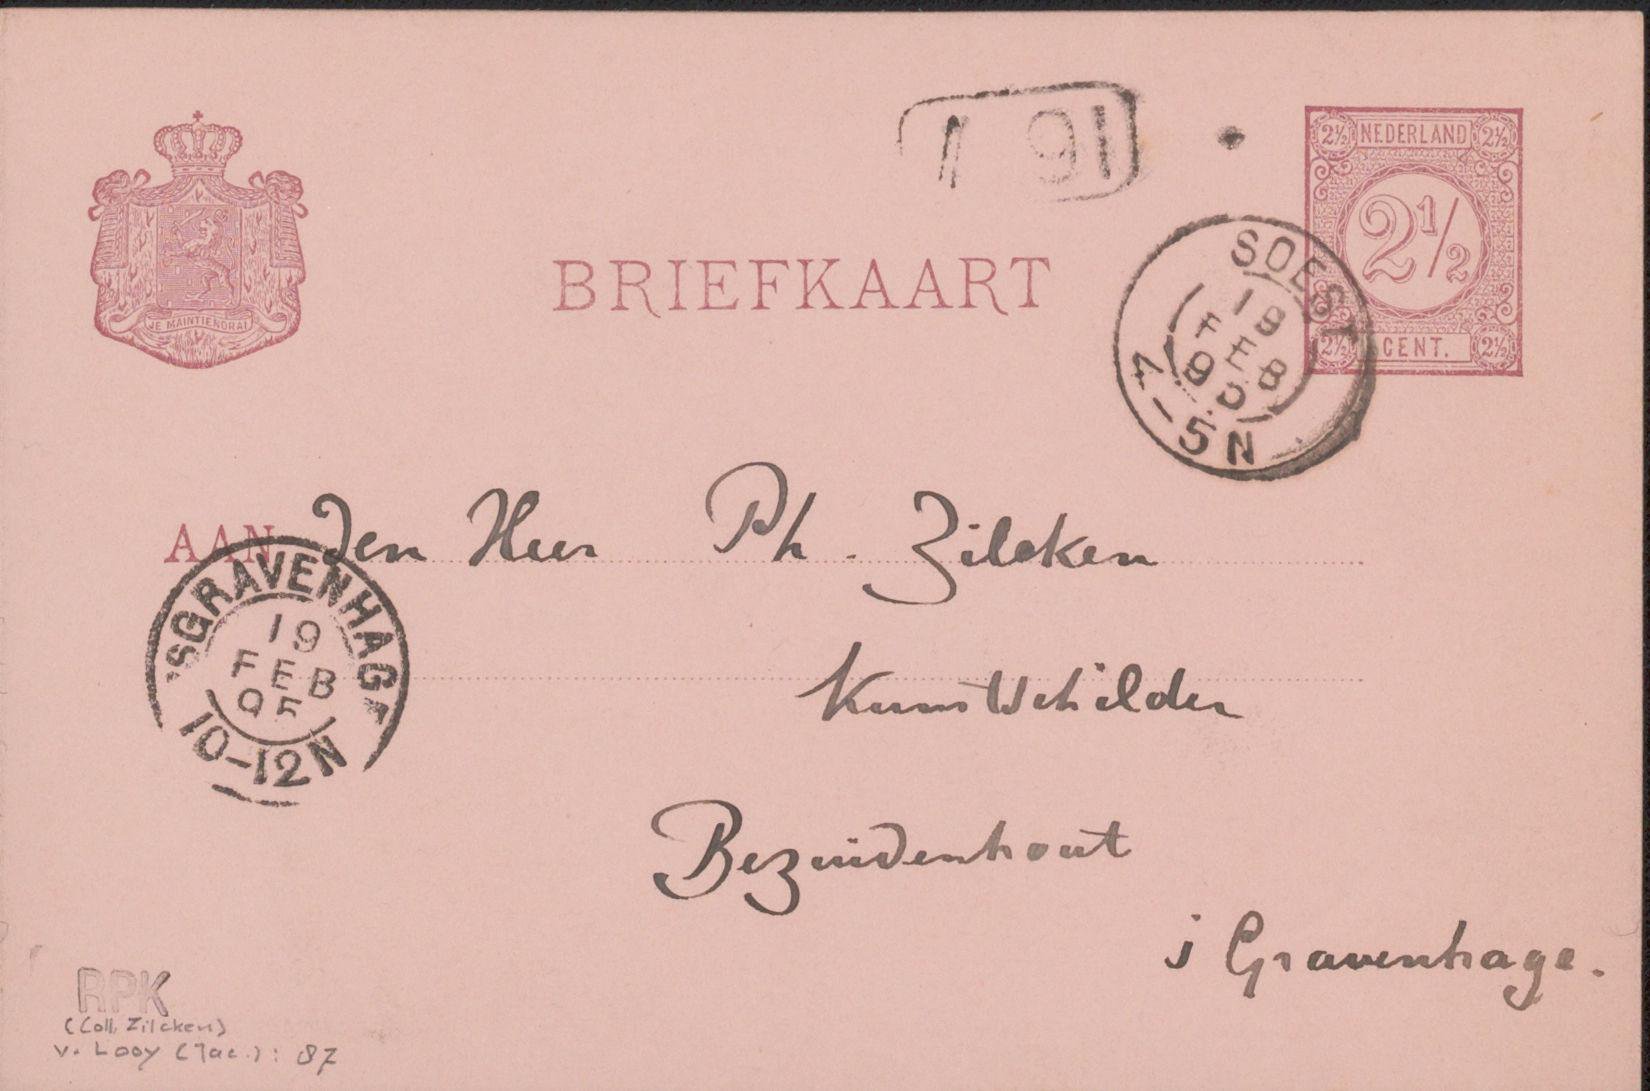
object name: postcard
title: Briefkaart aan Philip Zilcken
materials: cardboard, chalk, ink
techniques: pen, writing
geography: soest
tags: the hague, draughtsman, philip zilcken, the graphic arts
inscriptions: collector's mark: ‘RPK’